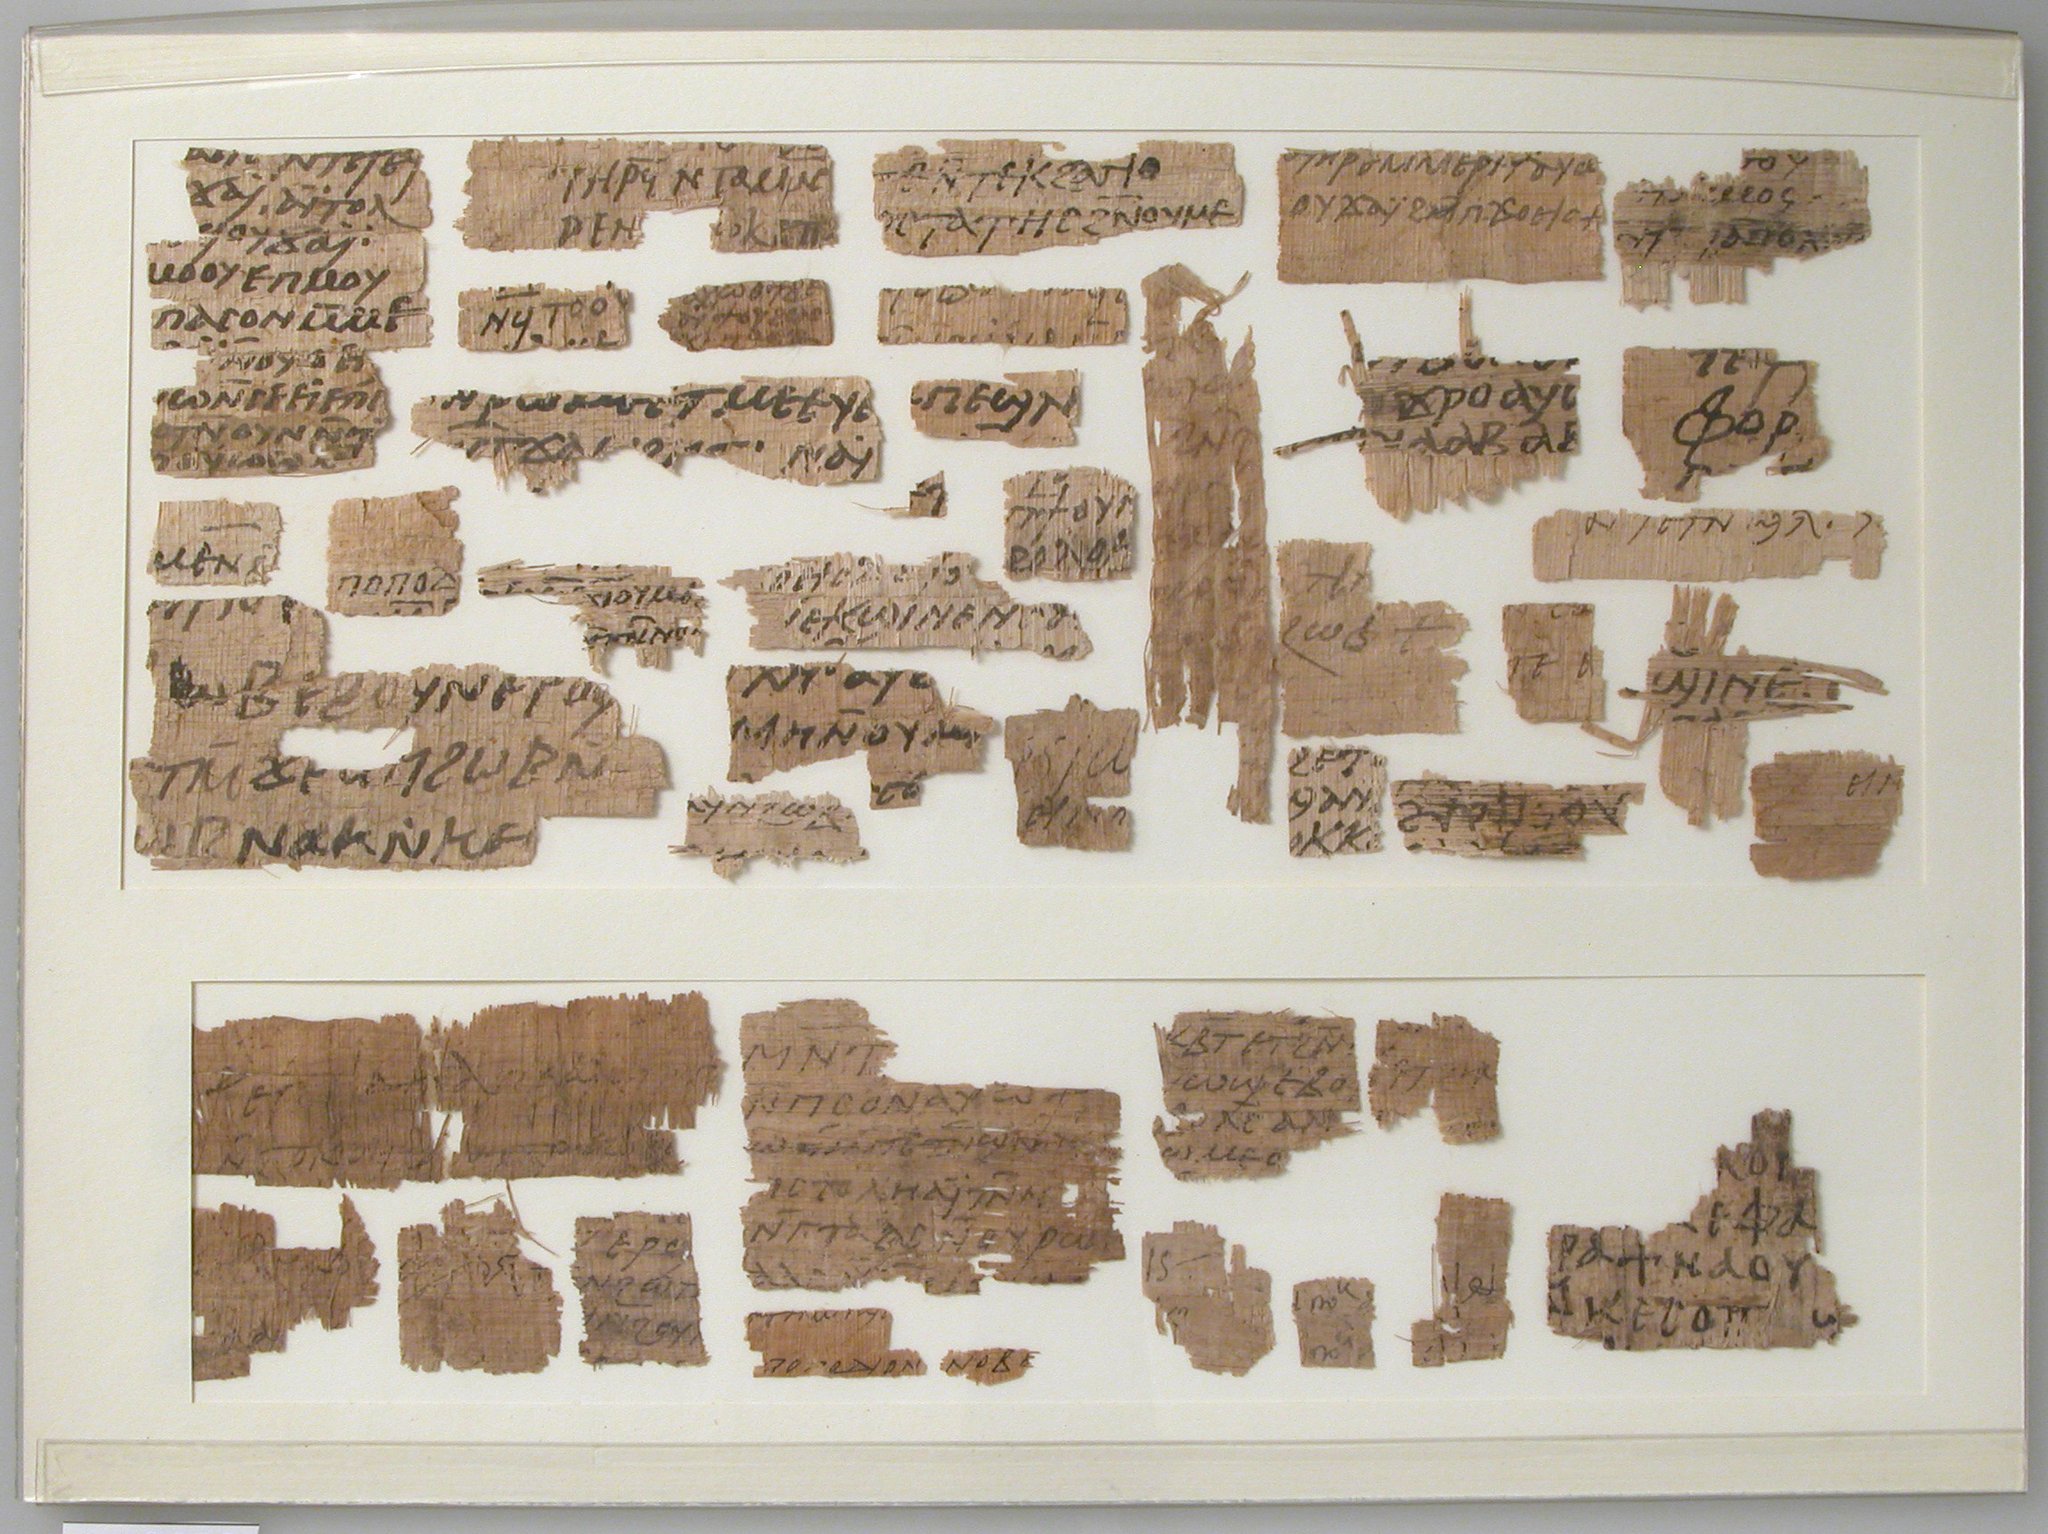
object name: fragment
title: Papyri Fragments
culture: coptic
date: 601-700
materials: ink, papyrus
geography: egypt